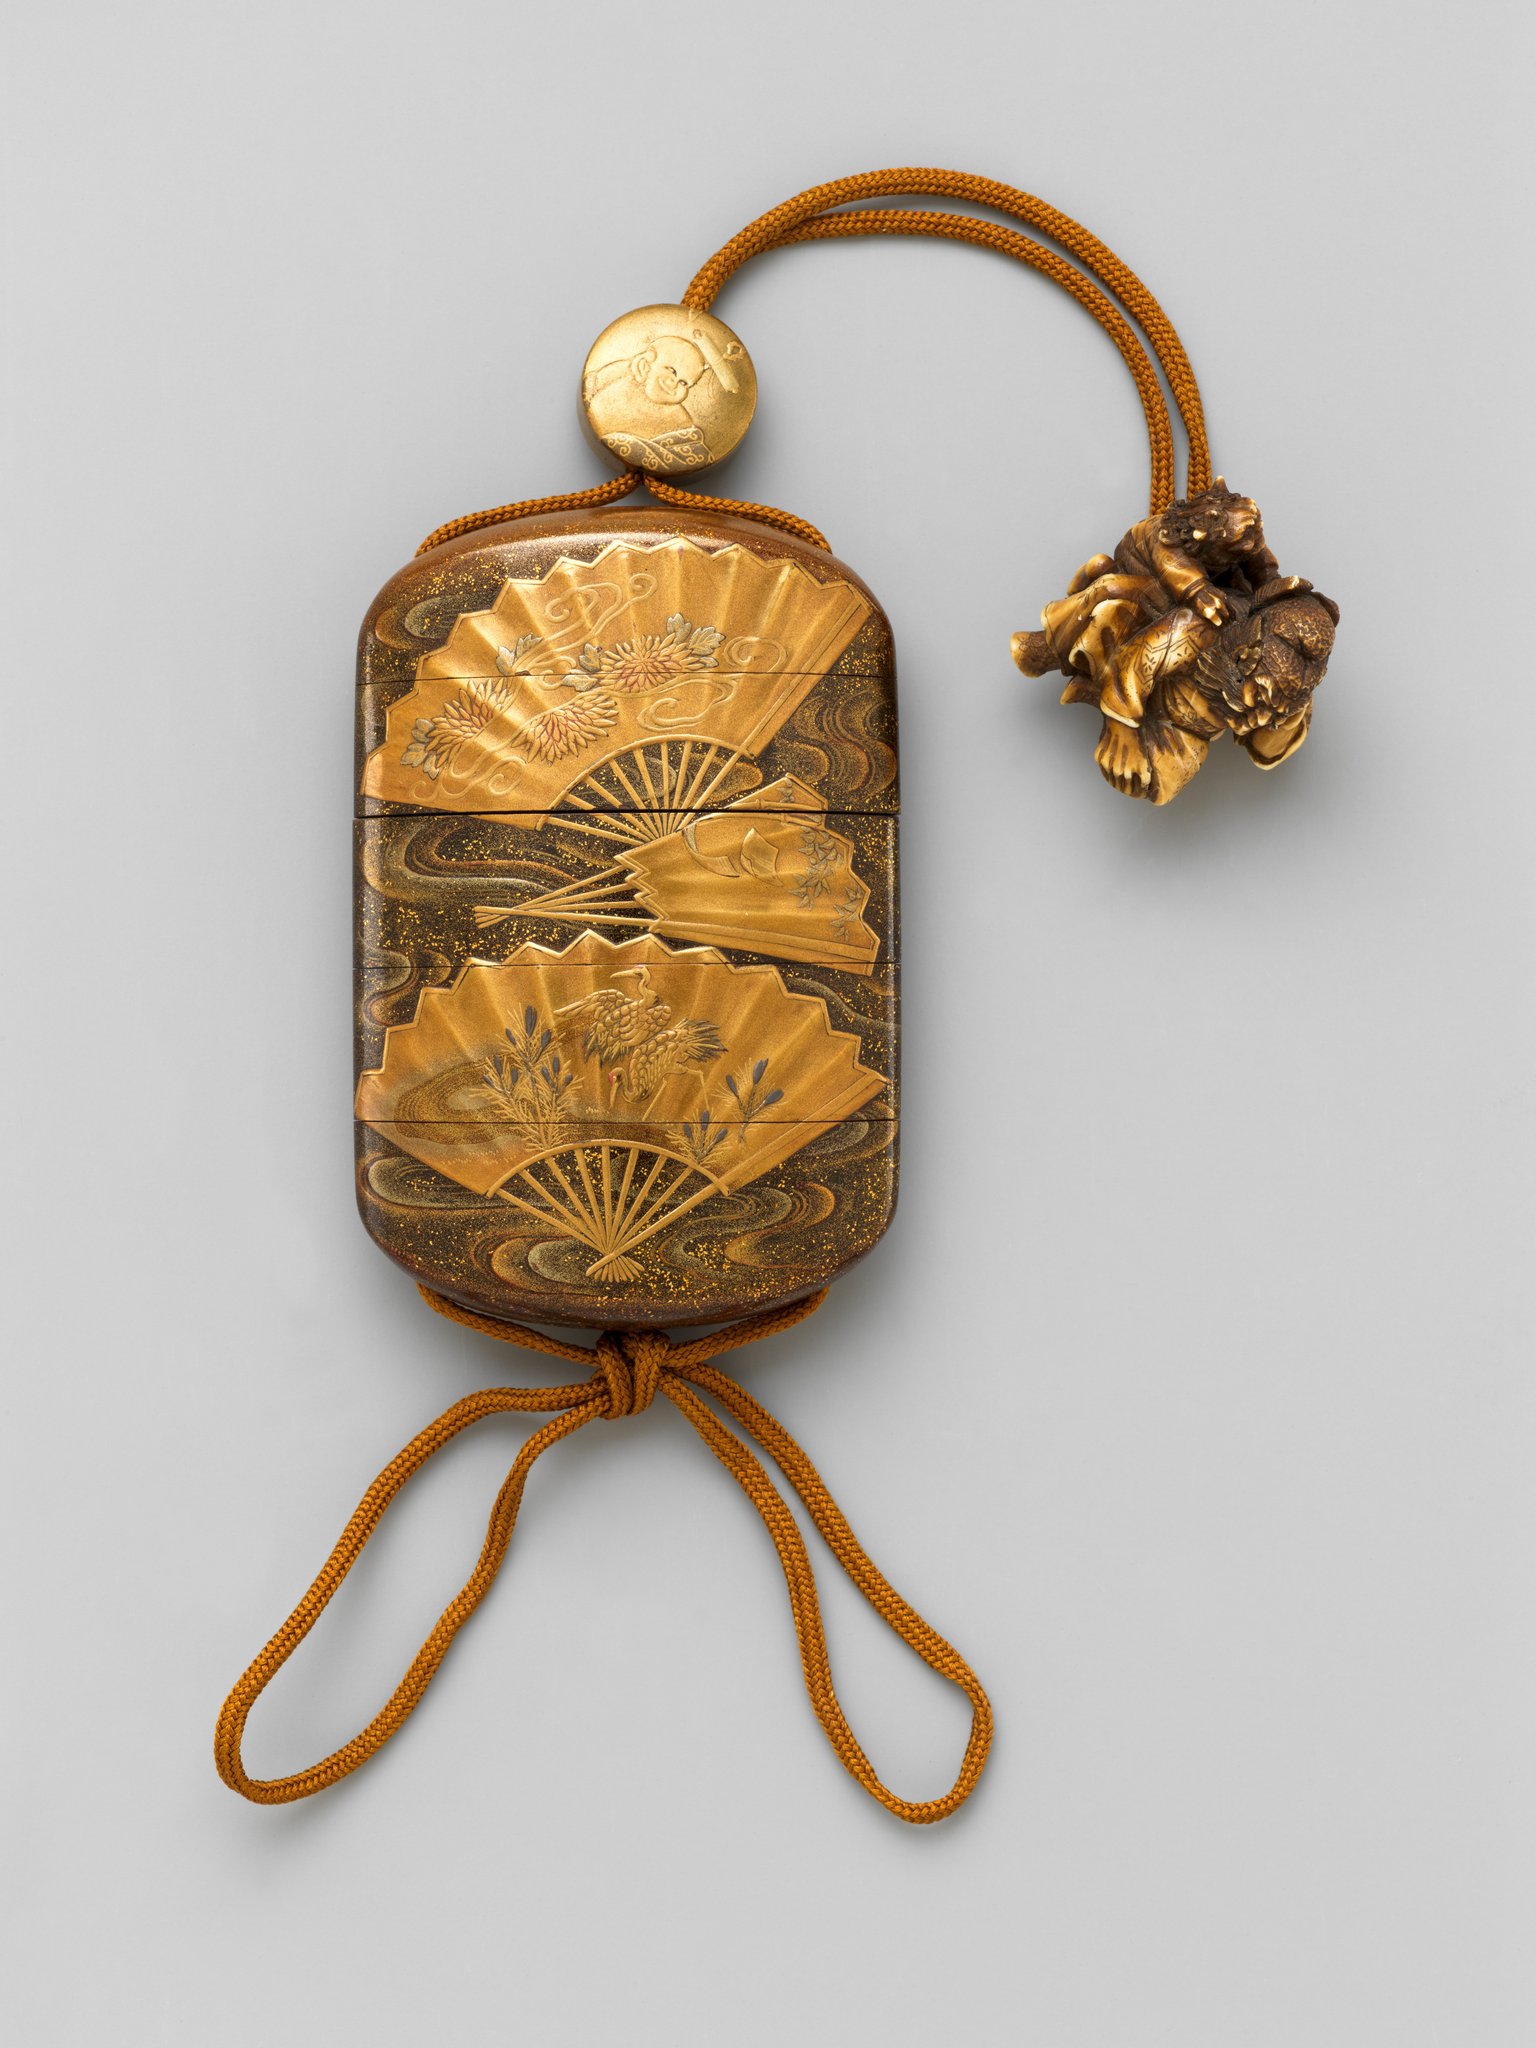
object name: inrō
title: Case (Inrō) with Design of Fans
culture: japanese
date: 1801-1833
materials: gold, ivory, lacquer, silver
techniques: maki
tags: birds,fans